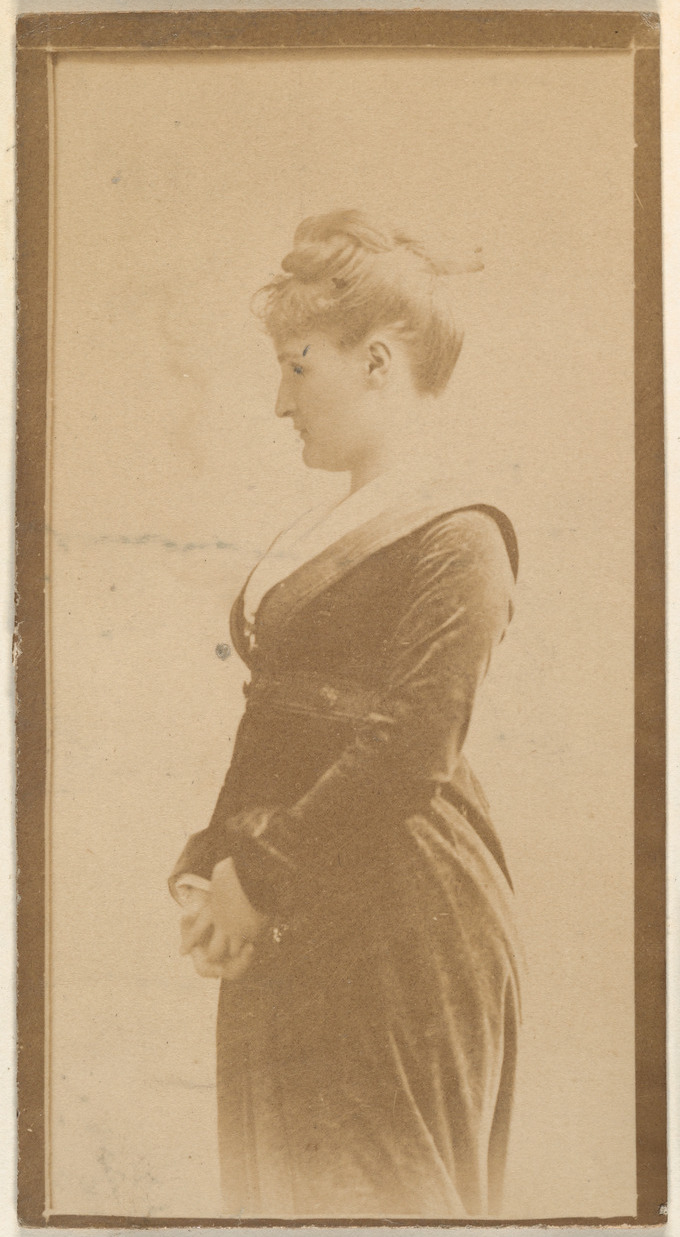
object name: photograph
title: Actress standing in profile, from the Actresses series (N668)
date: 1888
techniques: albumen silver print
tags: portraits,profiles,women,actresses